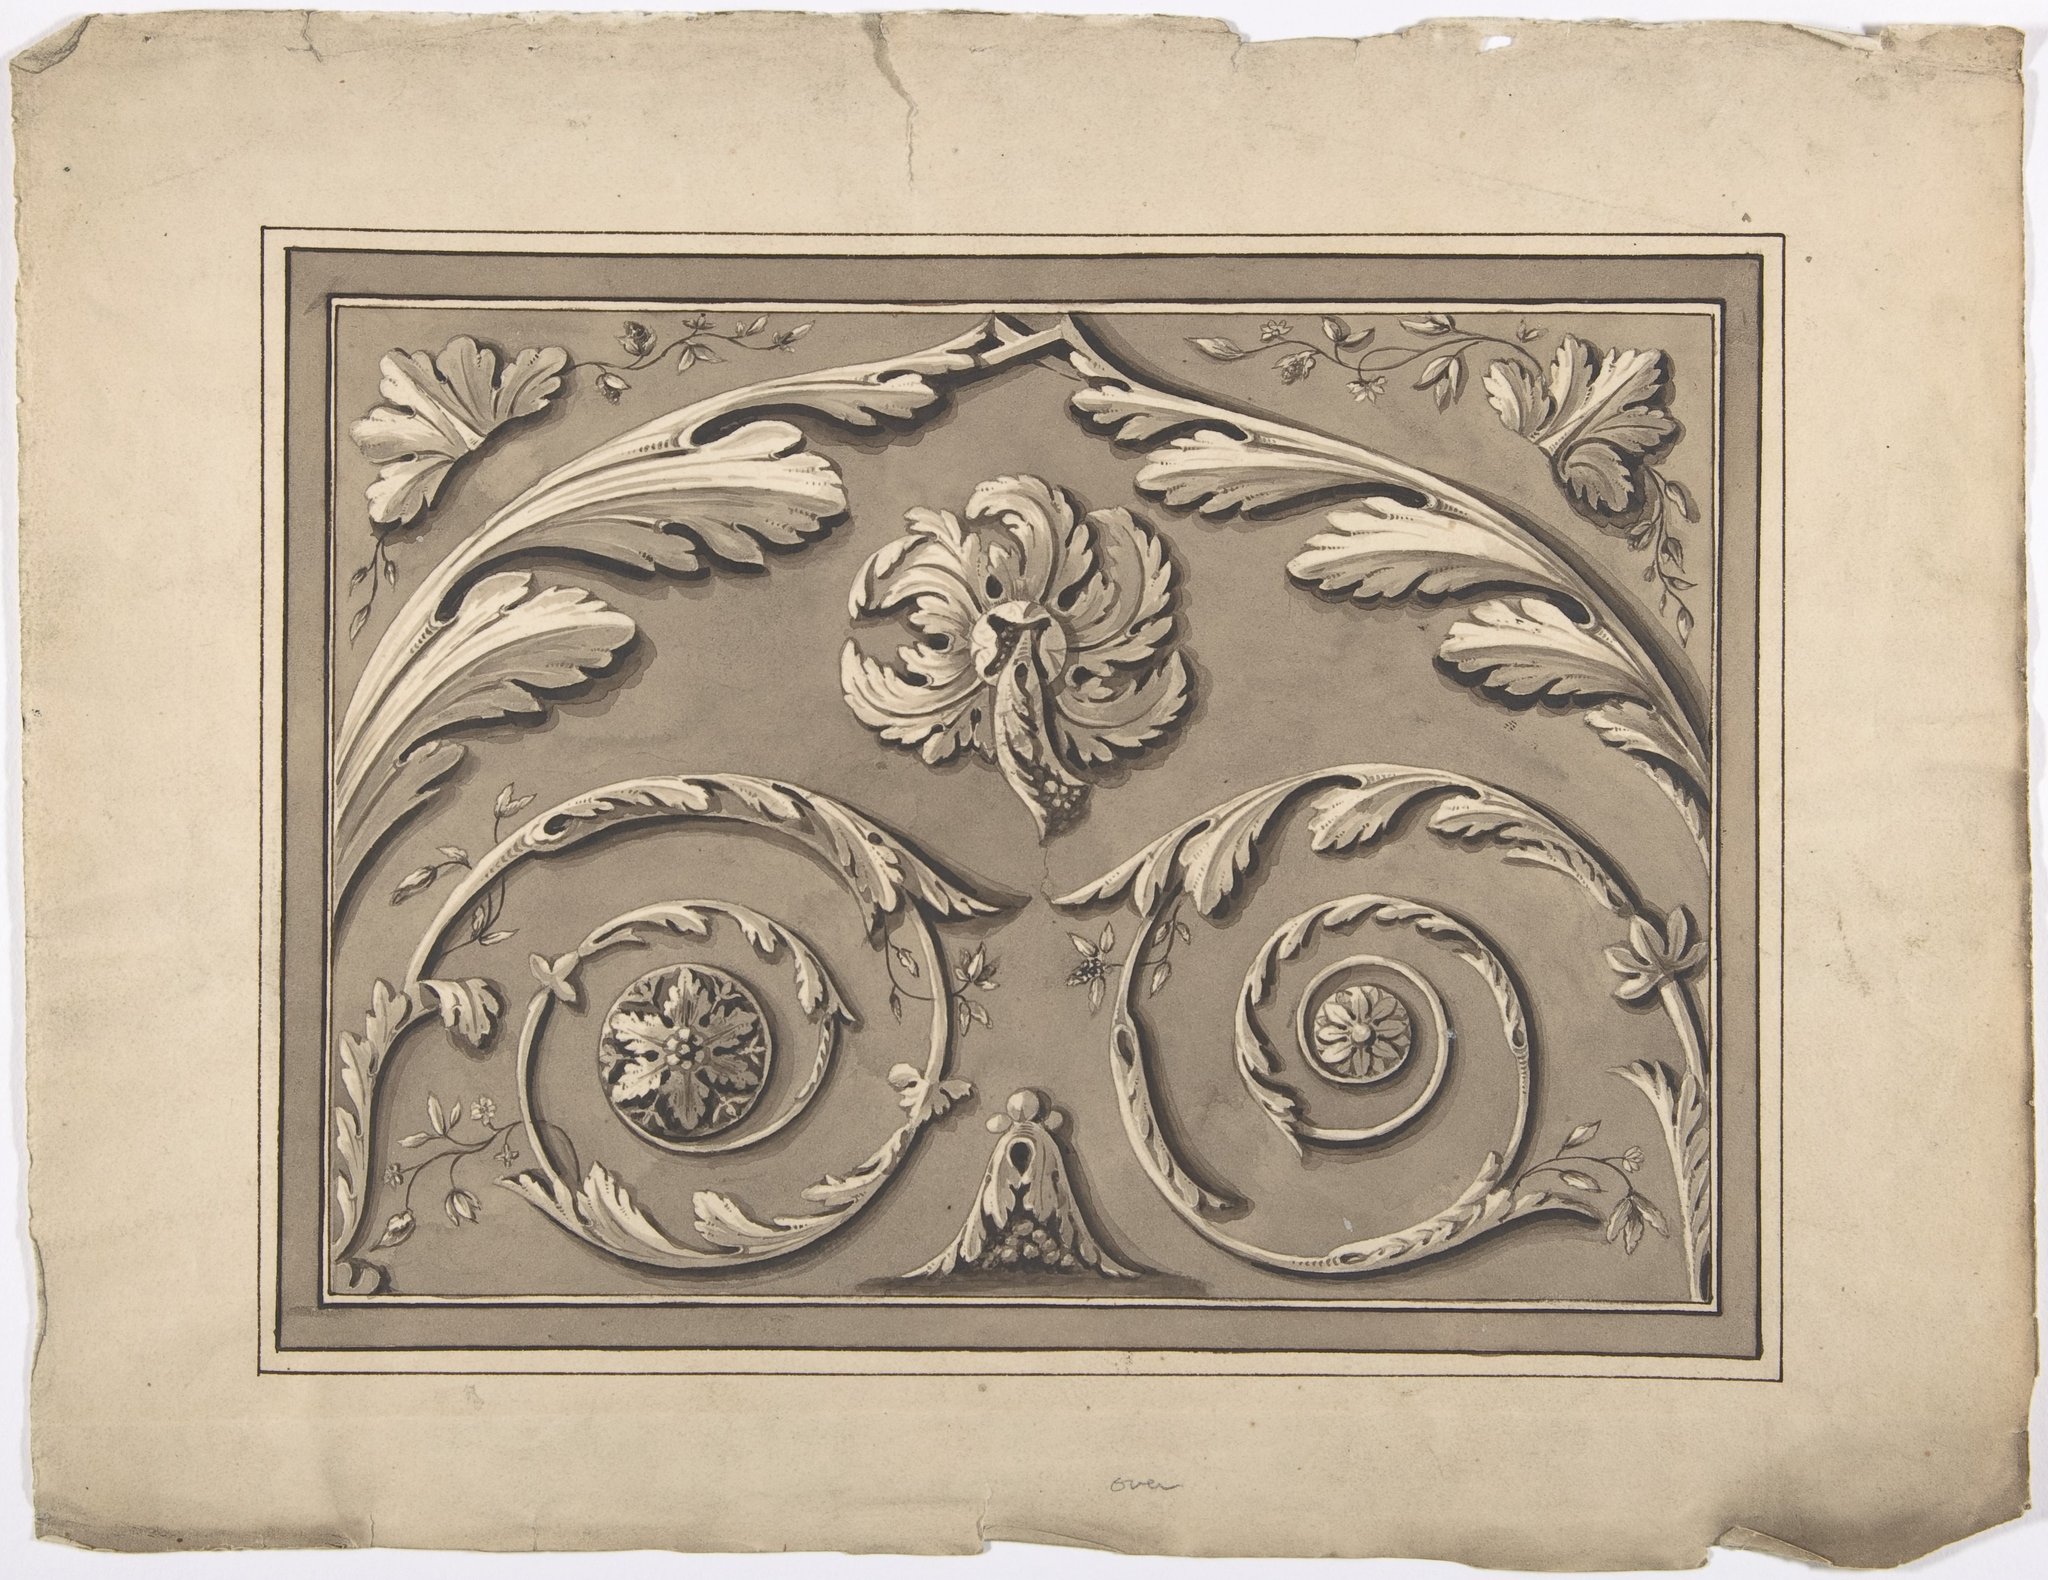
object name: drawing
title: Design for an Oblong Panel Carved with Foliage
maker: anonymous, british, 19th century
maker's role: artist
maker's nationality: british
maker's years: 1800-1900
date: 1822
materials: ink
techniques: brush, pen, wash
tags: ornament